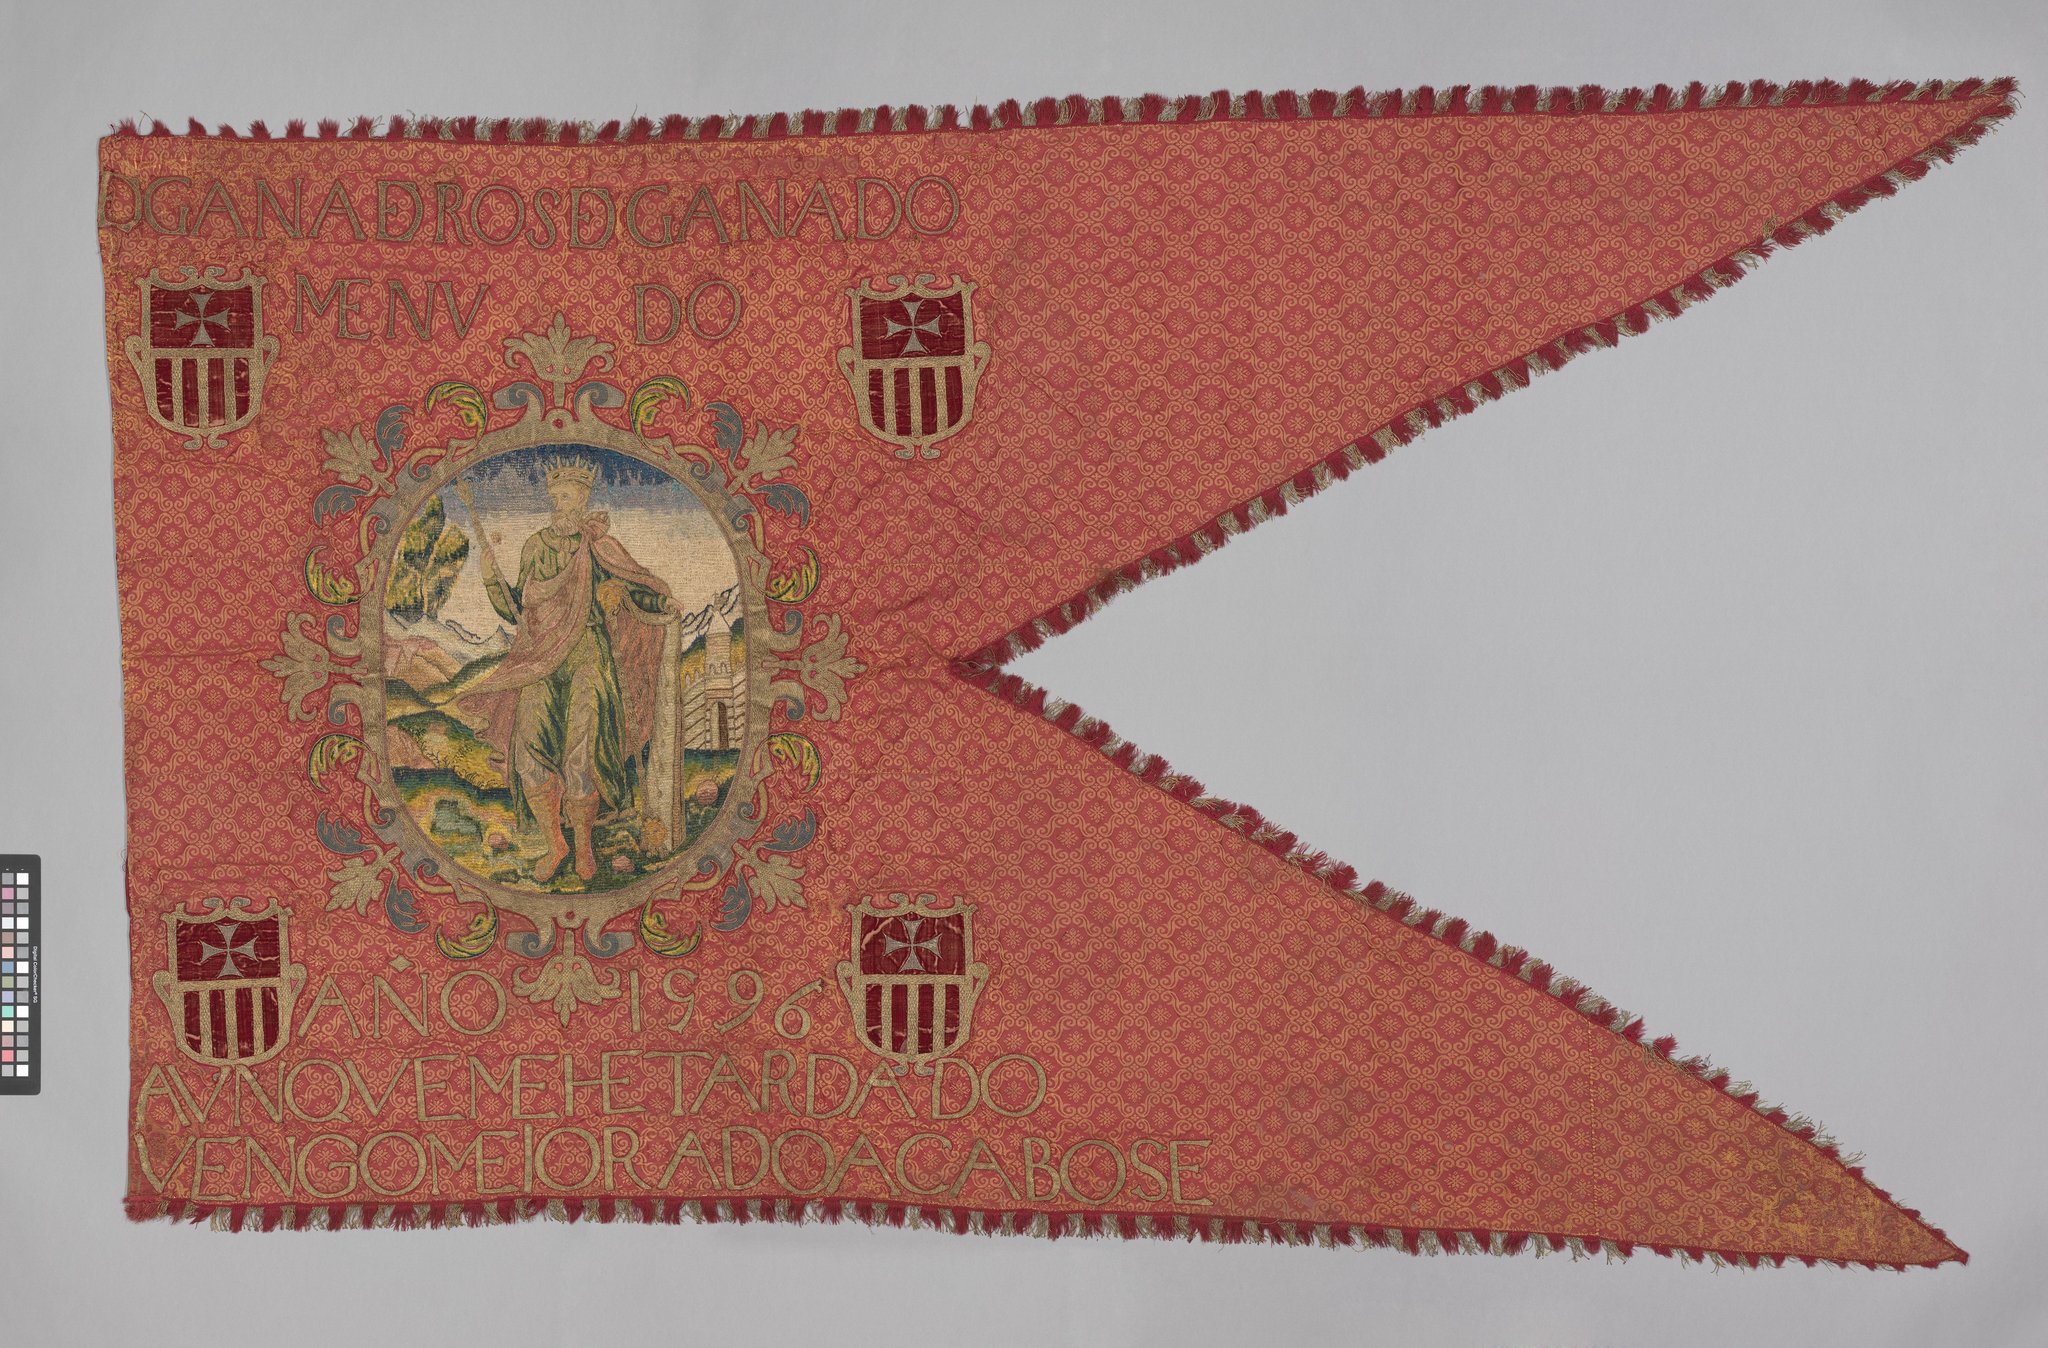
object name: banner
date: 1596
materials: metal thread, silk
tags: men,coat of arms,flags